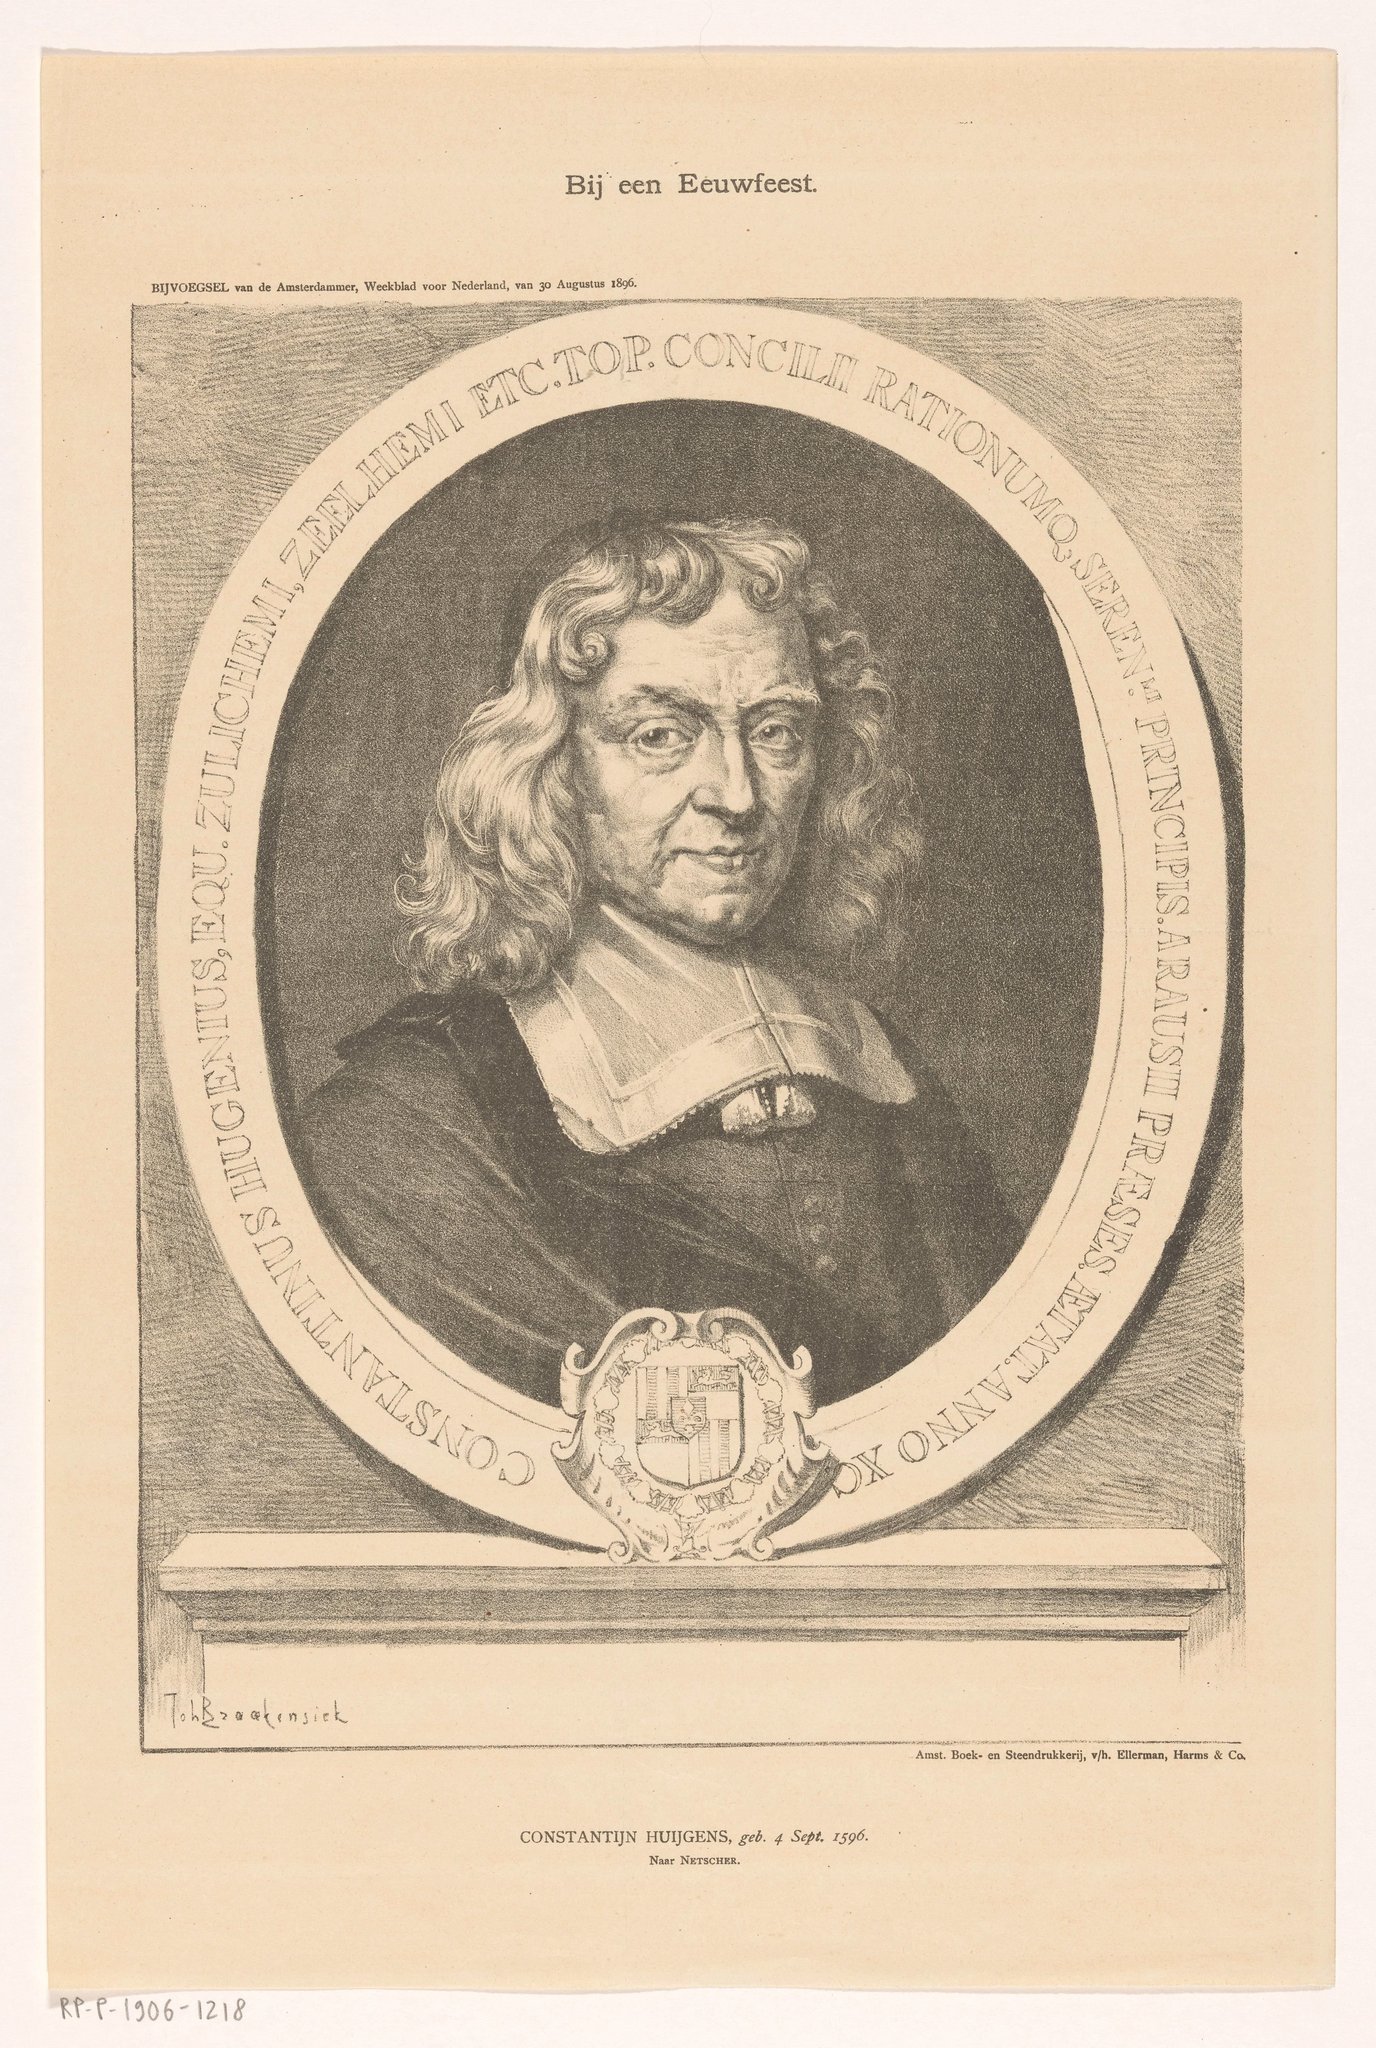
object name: print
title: Bij een eeuwfeest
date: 1896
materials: paper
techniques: lithograph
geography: amsterdam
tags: the hague, constantijn huygens (i), historical persons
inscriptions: collector's mark: Lugt 2228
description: Ovaal portret van Constantijn Huygens, omgeven door een kader met Latijnse tekst. Onder zijn portret het familiewapen.